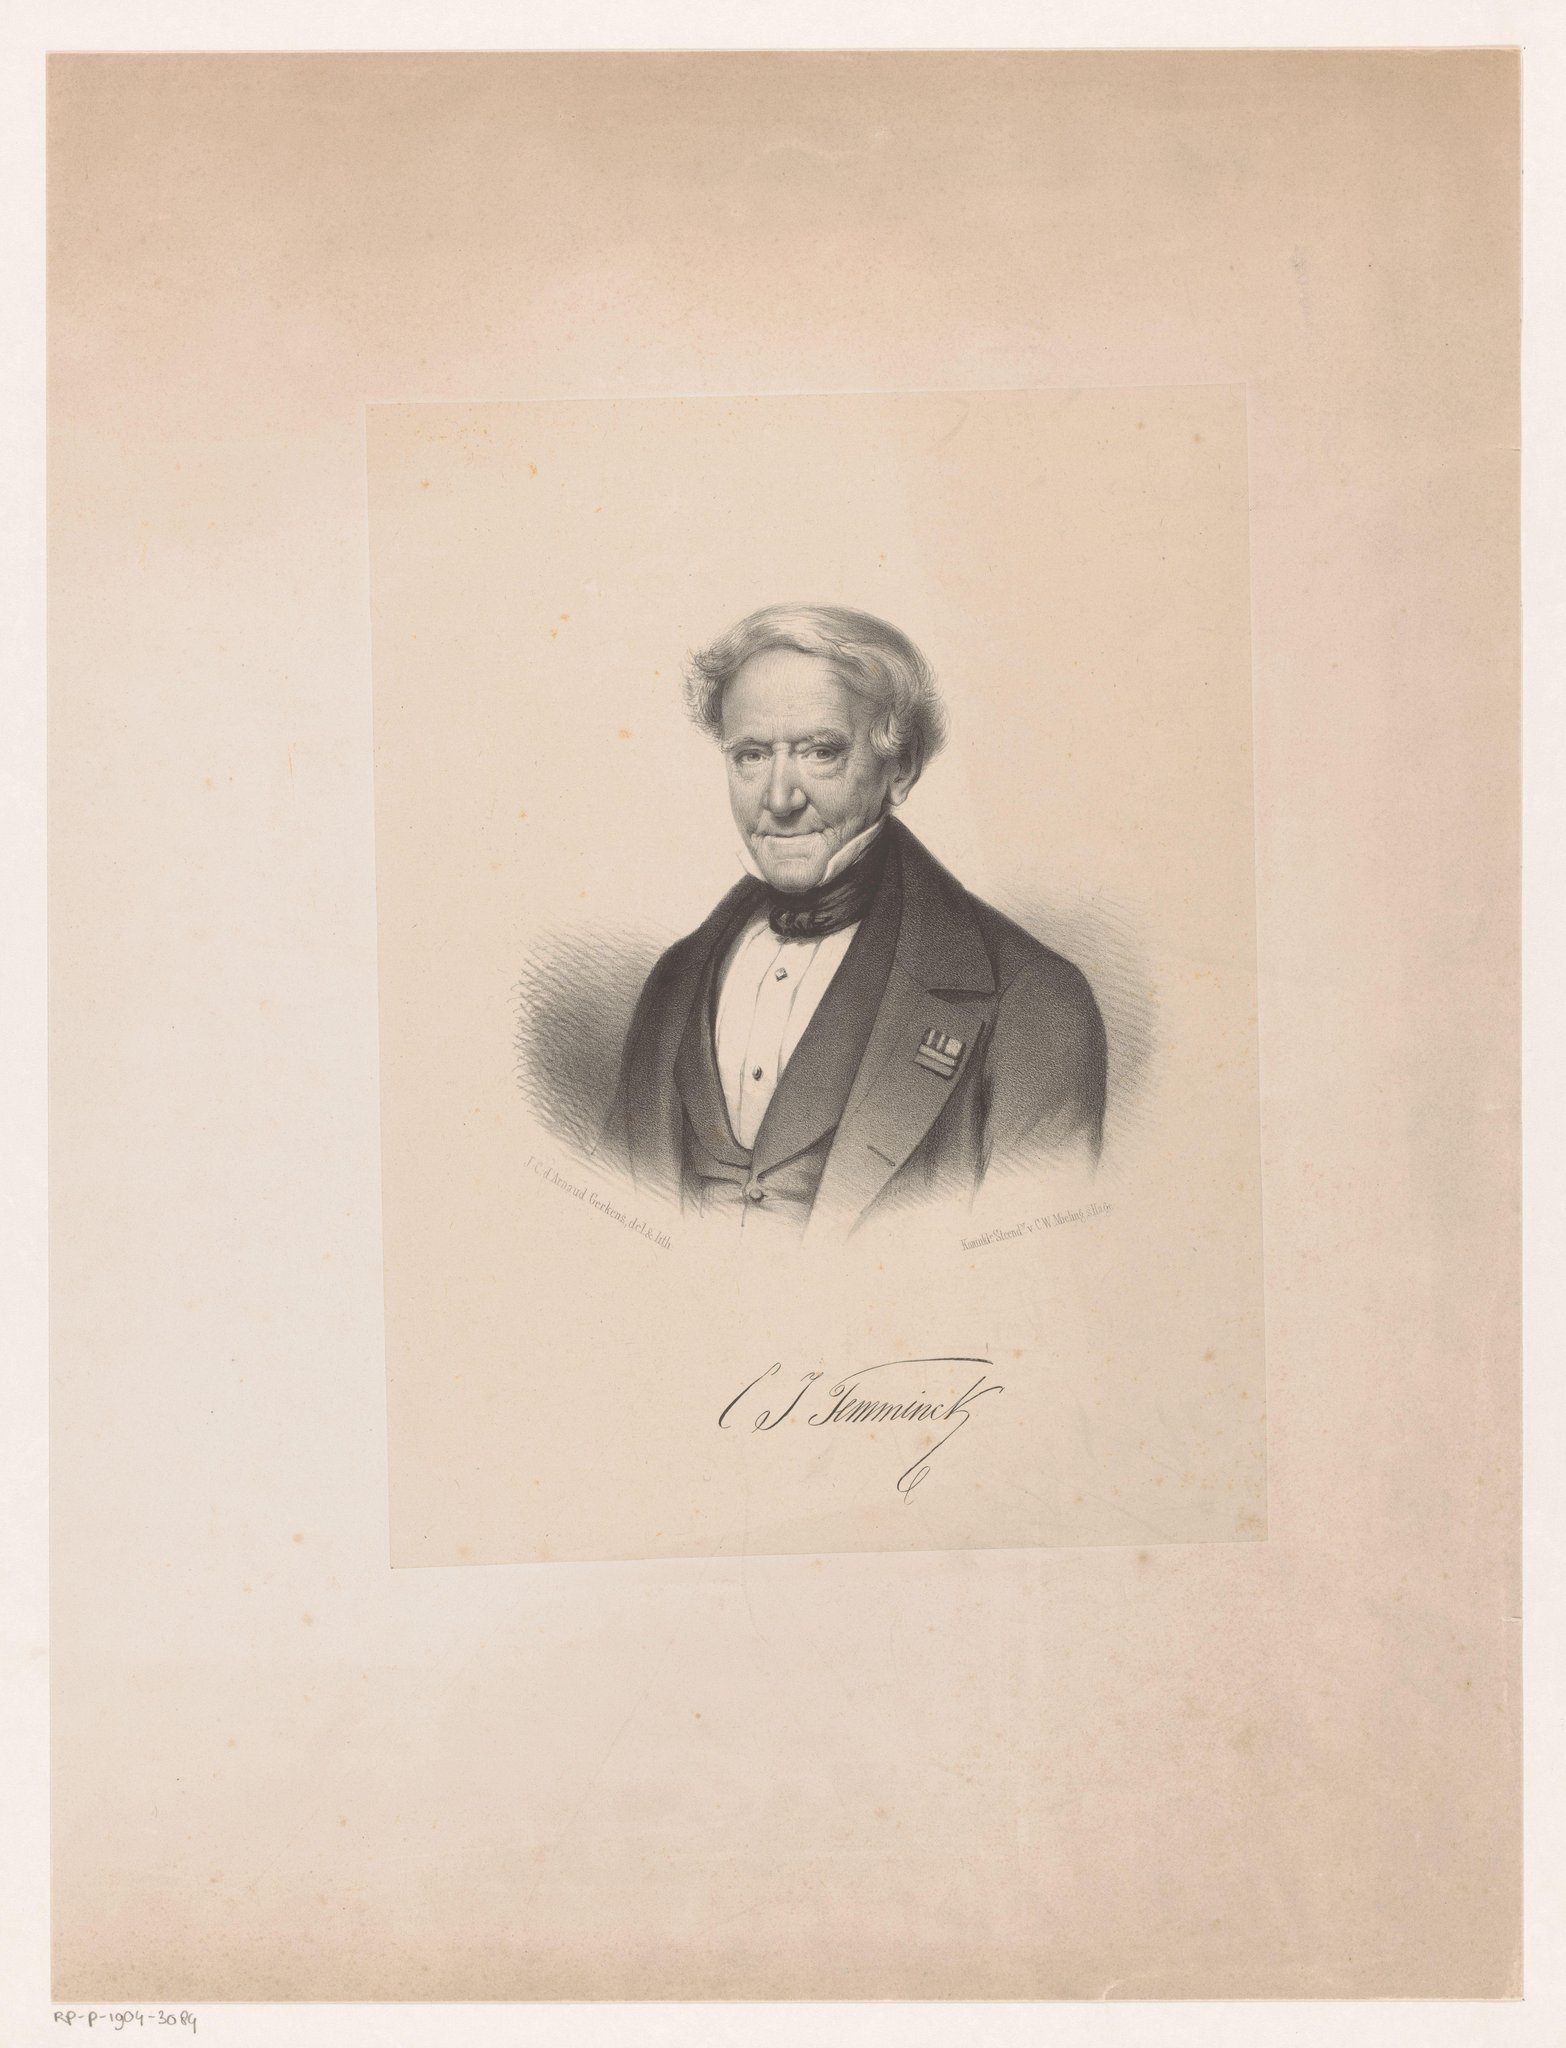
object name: print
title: Portret van Coenraad Jacob Temminck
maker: johannes christiaan d arnaud gerkens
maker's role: draughtsman, print maker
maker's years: 1823-1892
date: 1833-1858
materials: paper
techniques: lithograph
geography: netherlands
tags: amsterdam, knighthood order, historical persons (+ (full) bust portrait)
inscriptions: collector's mark: Lugt 2228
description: De geportretteerde draagt twee ordetekens in zijn knoopsgat. Onder het portret zijn signatuur.